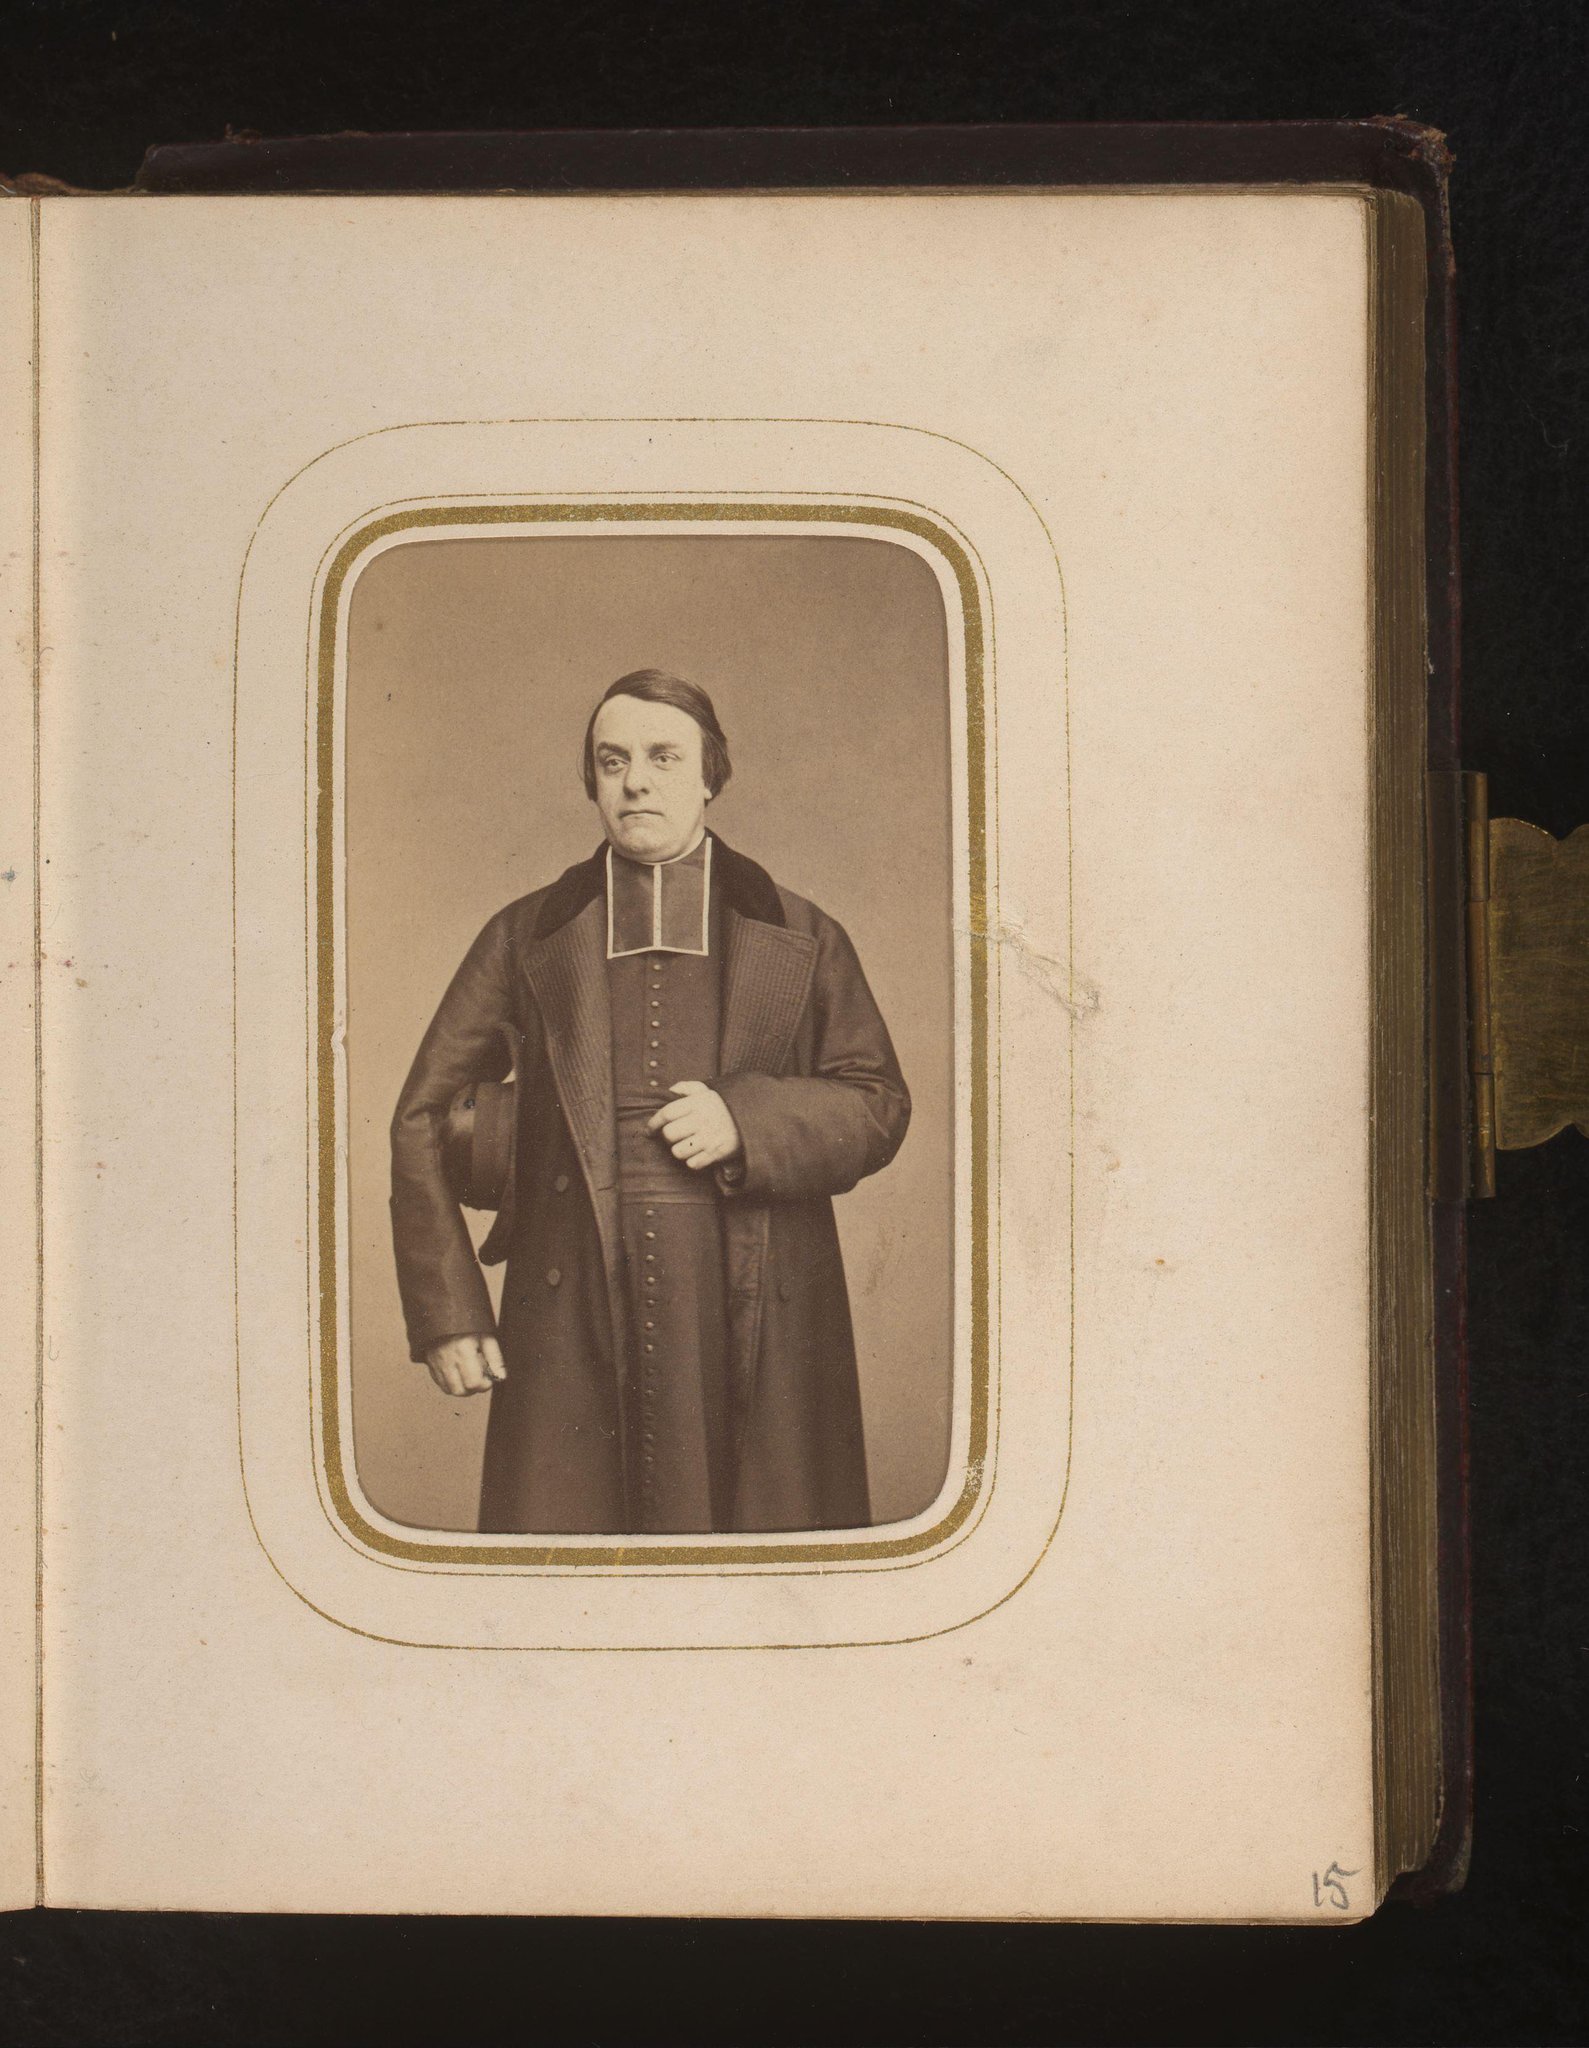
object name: photograph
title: Portret van een priester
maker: Anonymous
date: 1860-1900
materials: cardboard, photographic support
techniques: albumen print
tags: historical persons